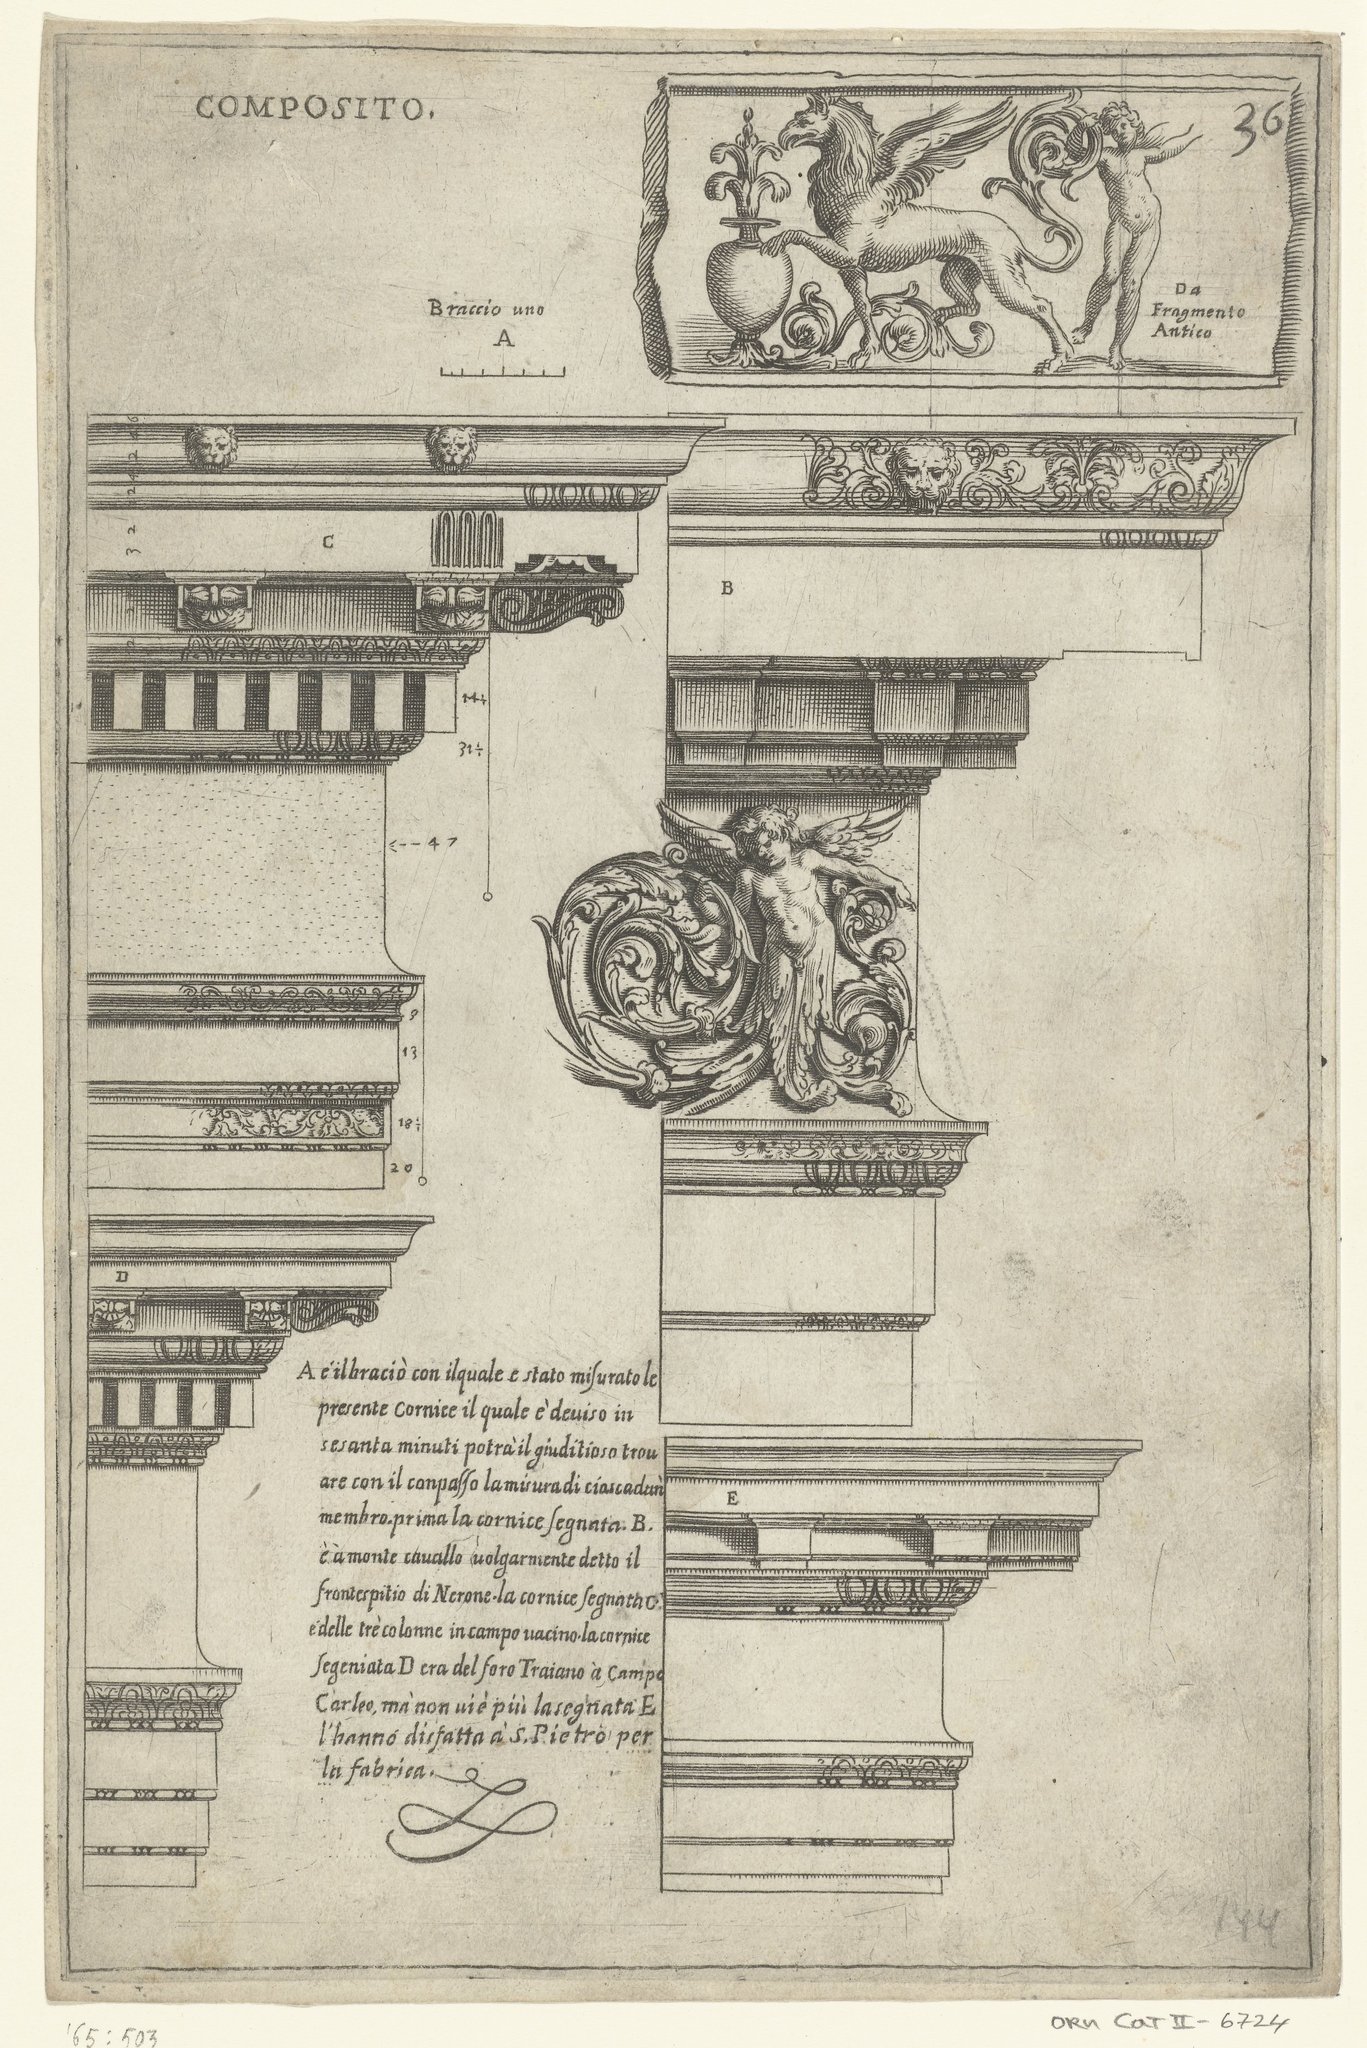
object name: print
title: Fries en vier hoofdgestellen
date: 1636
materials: paper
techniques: engraving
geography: italy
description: Linksonder staat tekst. De laatste drie regels vervangen de niet langer actuele informatie over het hoofdgestel van het Forum van Trajanus, gebruikt na 1638 voor de bouw van de Sint-Pietersbasiliek. Uit eerste editie.